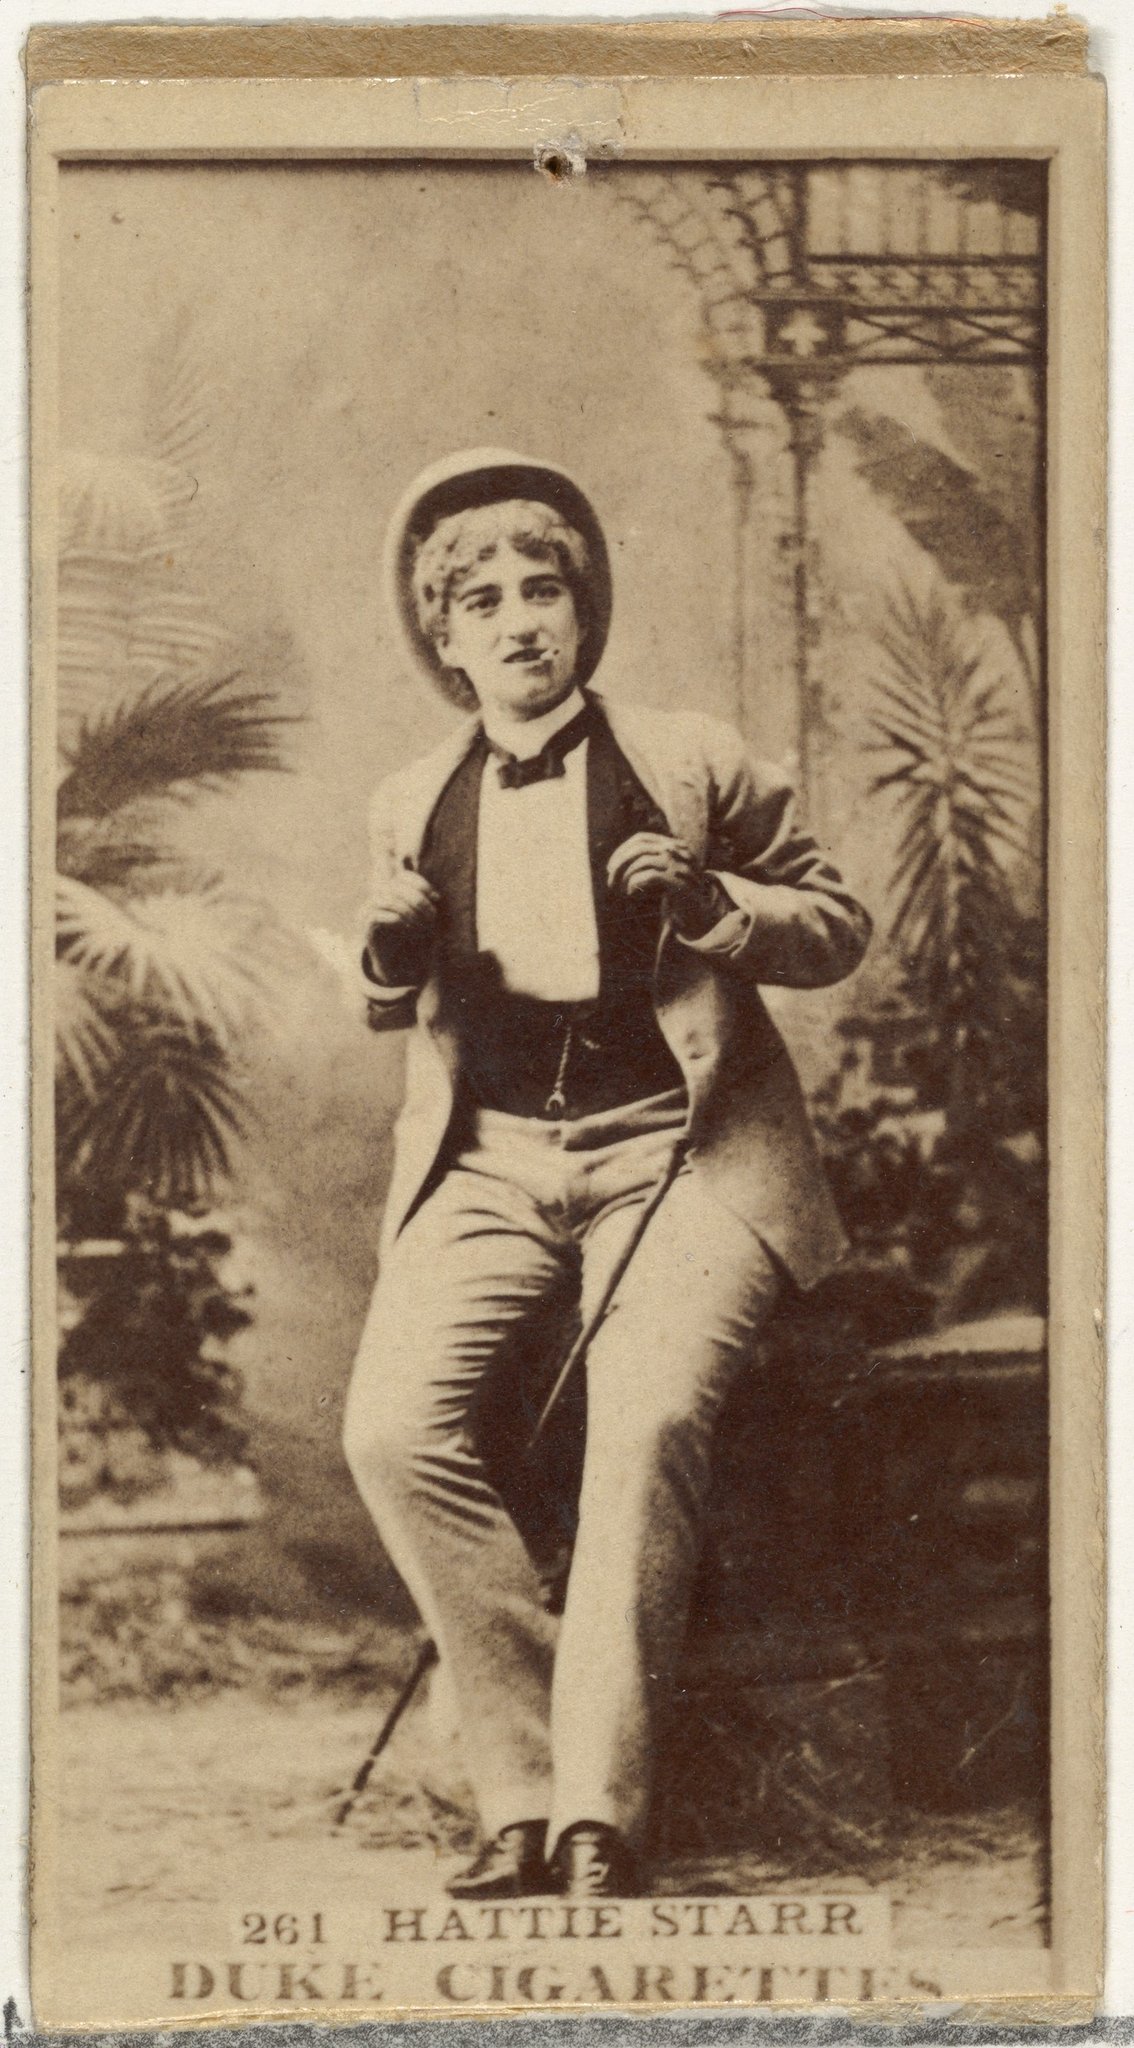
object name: photograph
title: Card Number 261, Hattie Starr, from the Actors and Actresses series (N145-7) issued by Duke Sons & Co. to promote Duke Cigarettes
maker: w. duke, sons & co.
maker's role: publisher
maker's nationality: american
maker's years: 1870-1920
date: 1880-1889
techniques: albumen silver print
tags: portraits,women,actresses